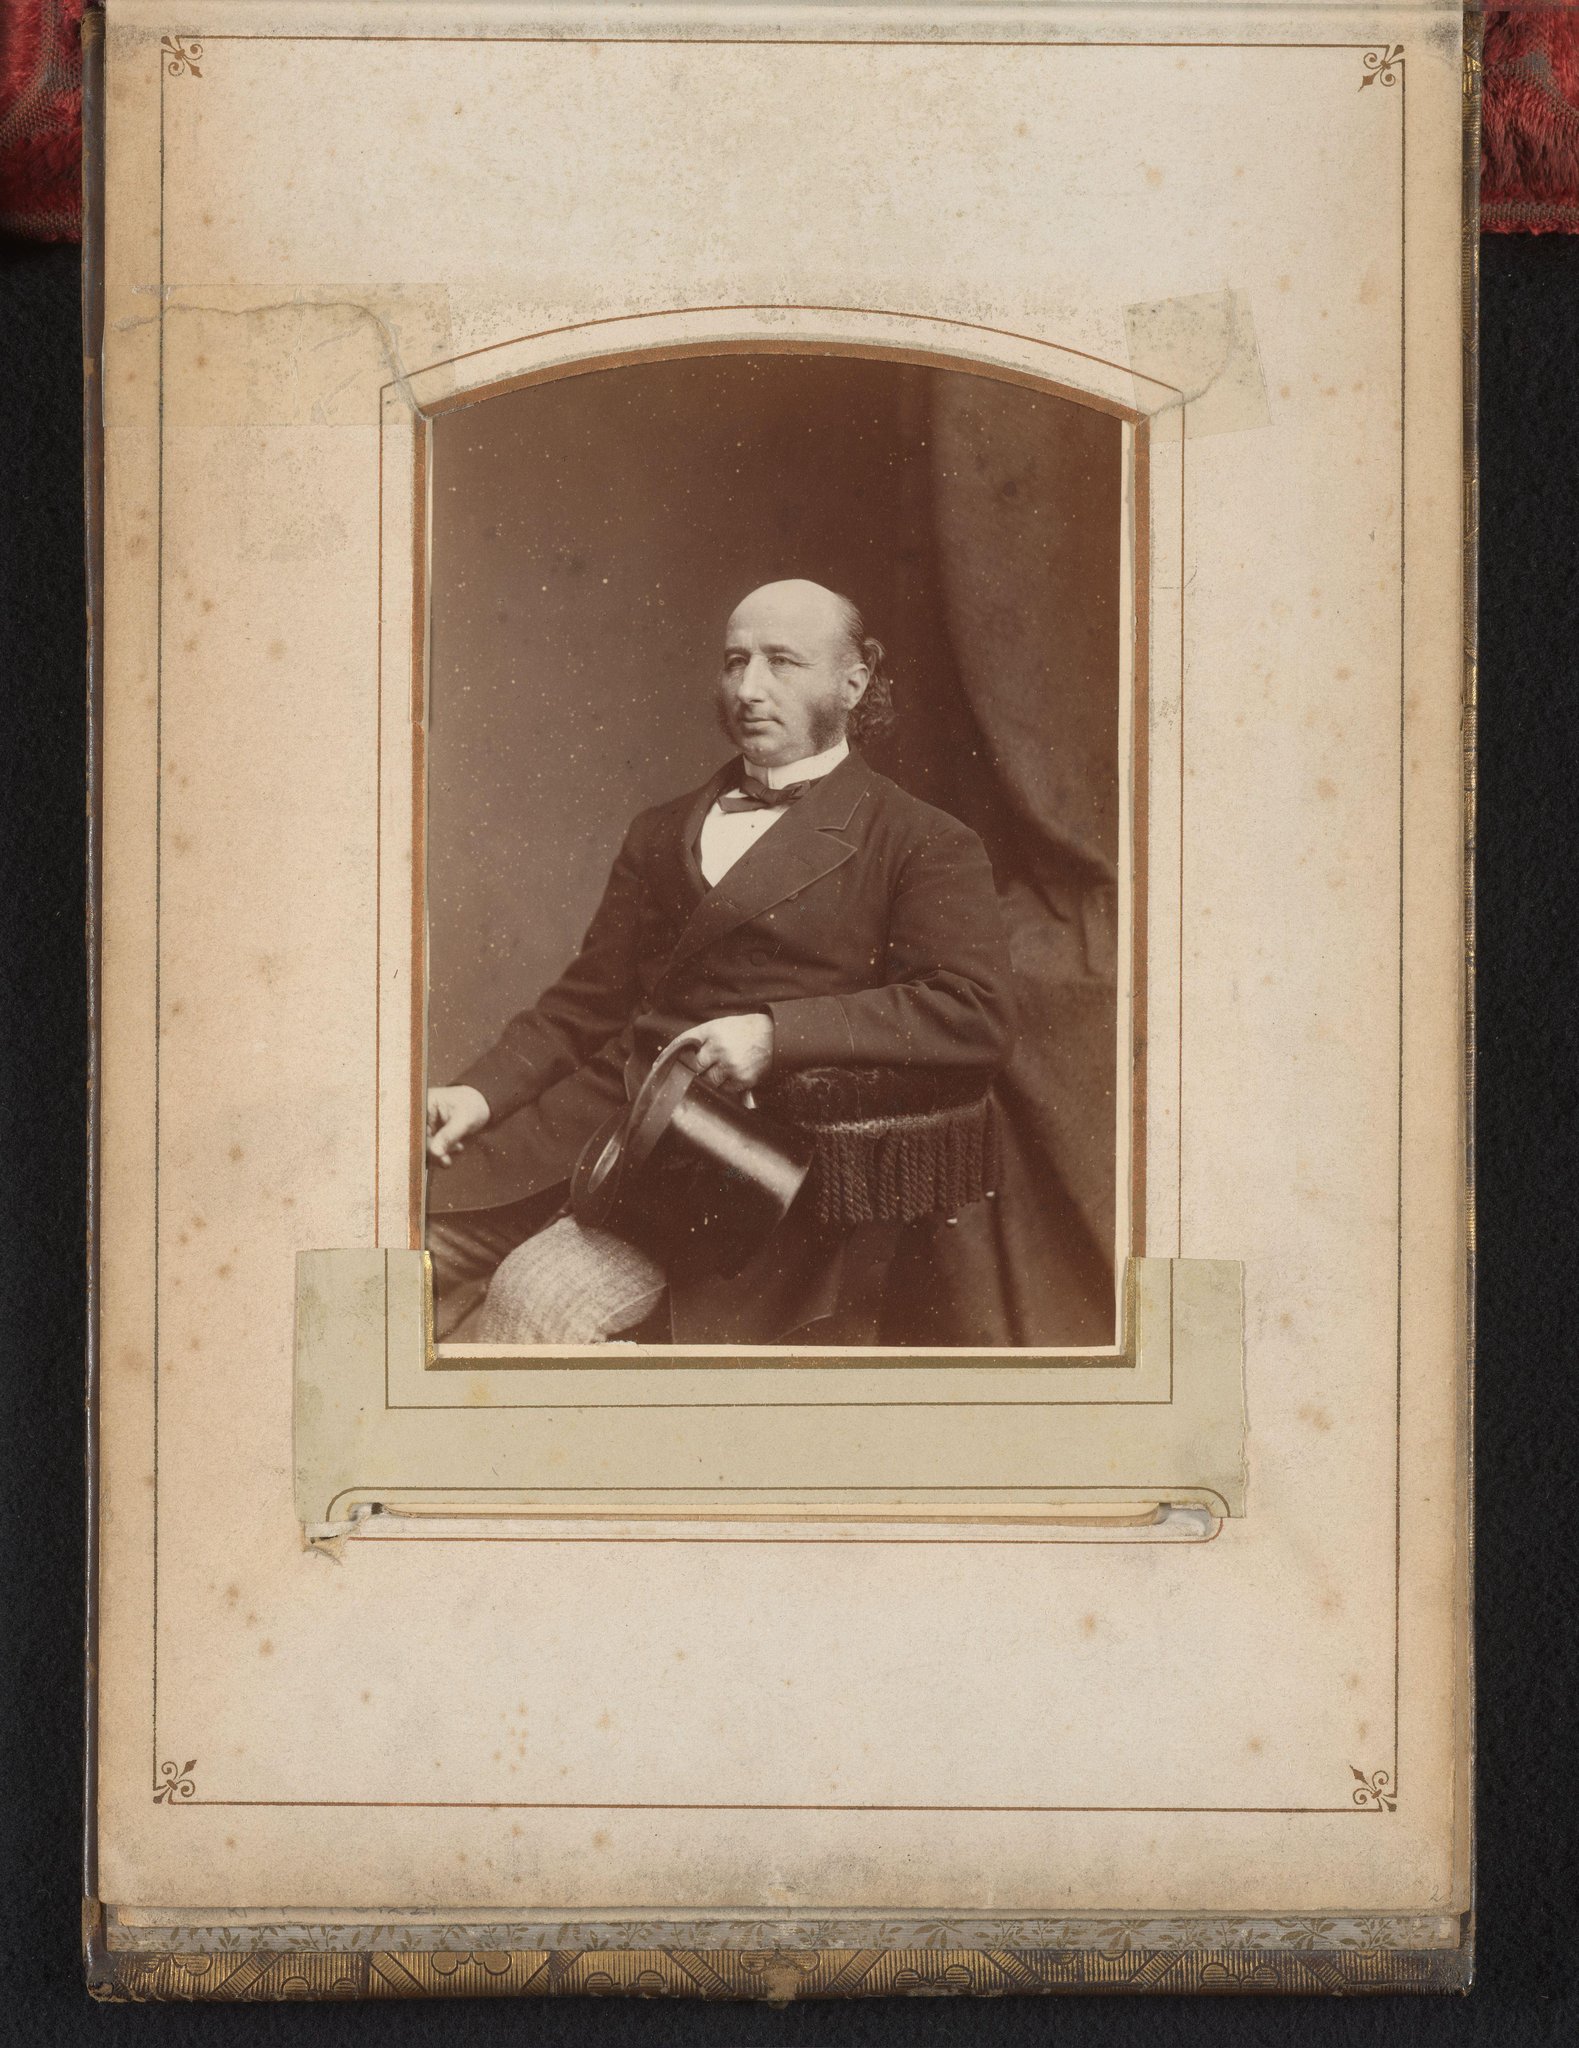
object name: cabinet photograph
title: Portret van een zittende man met hoge hoed in de hand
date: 1860-1900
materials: cardboard, photographic support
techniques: albumen print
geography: copenhagen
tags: sitting figure, historical persons, head-gear: top hat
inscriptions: inscription: ‘Photographiske Etablissement/ af/ Hansen & Weller/ 15, Östergade 15./ Kjöbenhavn.’